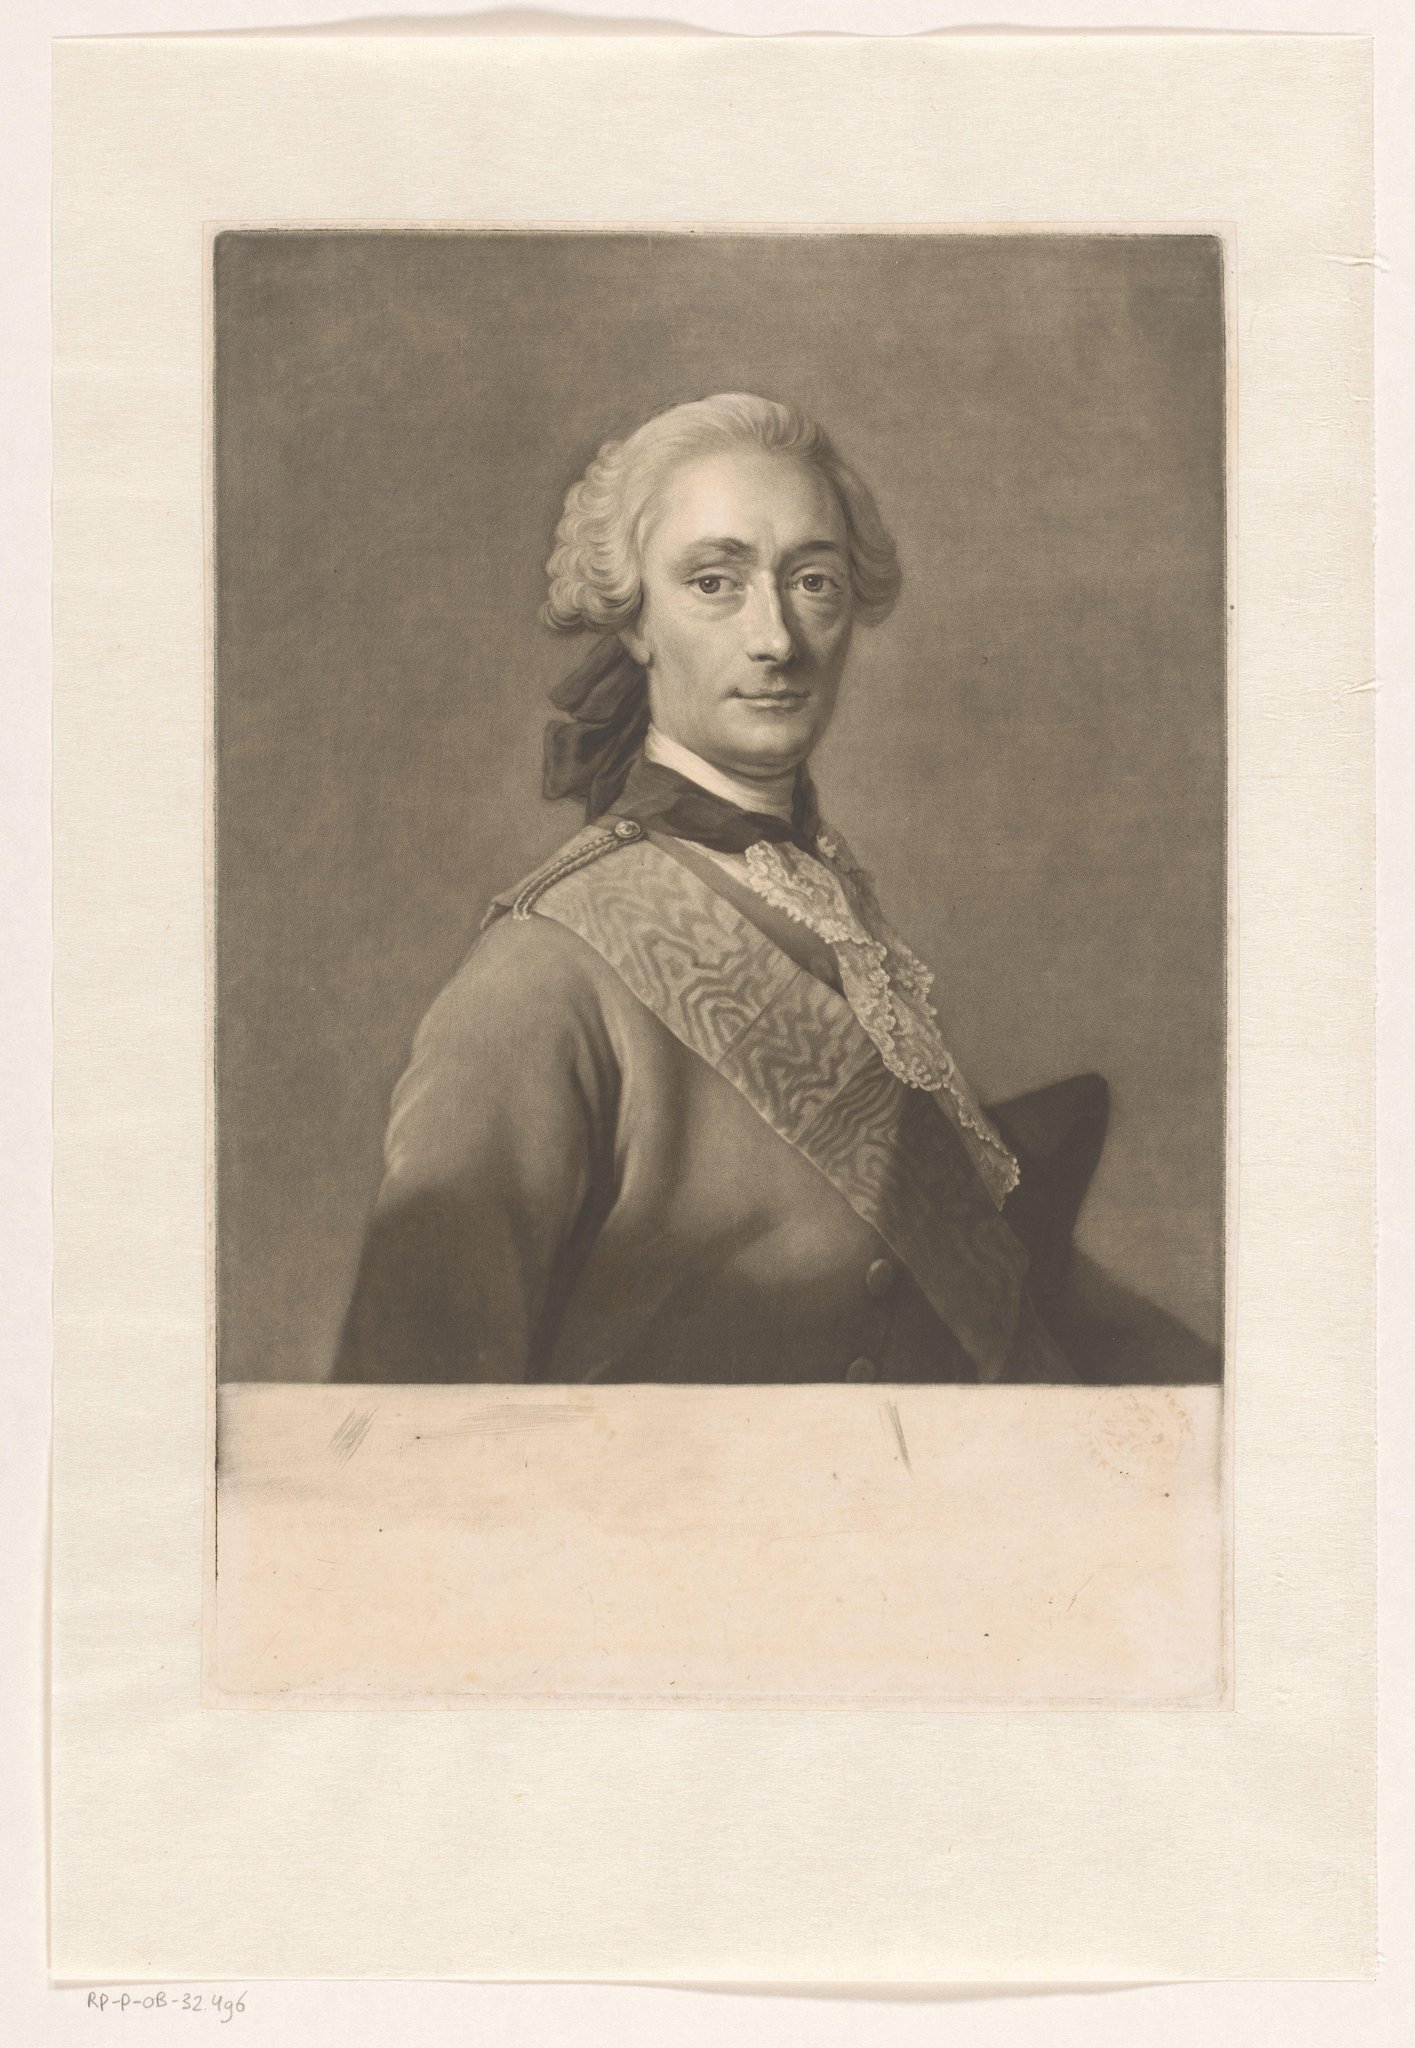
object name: print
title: Portret van Louis Jules Mancini Mazarini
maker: james mcardell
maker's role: print maker, publisher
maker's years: 1728-1765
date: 1764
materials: paper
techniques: mezzotint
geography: london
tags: paris, louis jules mancini mazarini, historical persons, diplomacy, diplomat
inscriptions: collector's mark: Lugt 240